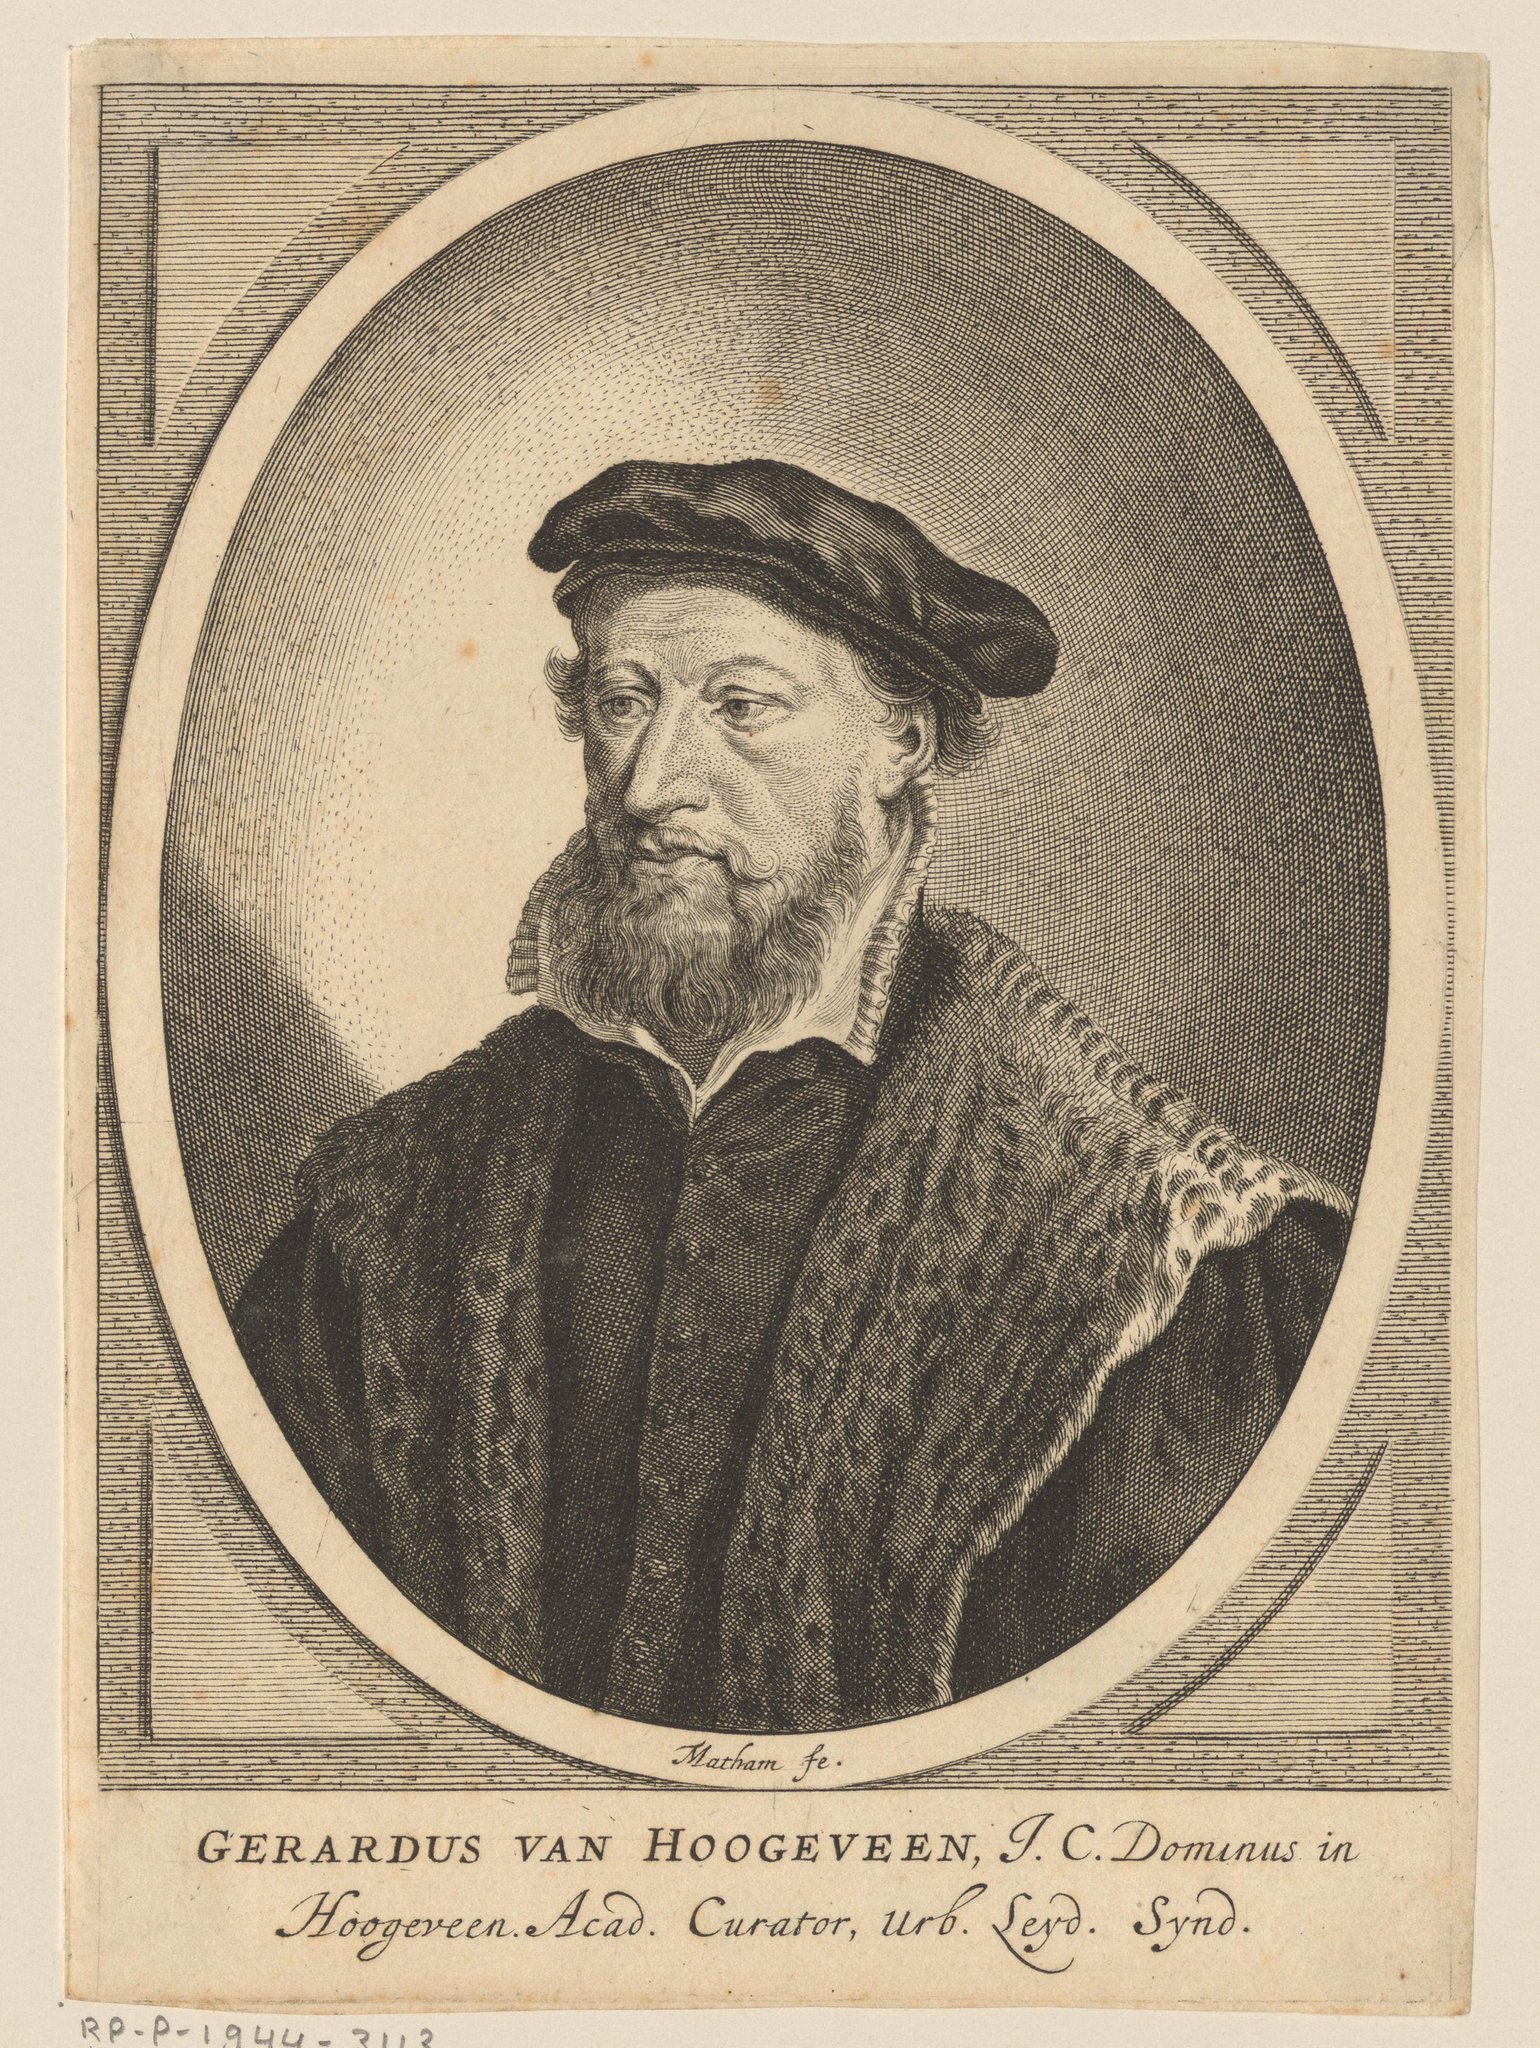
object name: print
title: Portret van Gerardus Amelisz. van Hoogeveen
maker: theodor matham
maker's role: draughtsman, print maker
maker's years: 1605-1676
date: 1621-1676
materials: paper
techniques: engraving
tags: historical persons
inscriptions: collector's mark: Lugt 2228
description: Prent met tekst op verso gebruikt in: Colonius, Daniel. Vita Gerardi Aemilii van Hoogeveen (...). Leiden: weduwe en erven Johannes Elsevier, 1666.